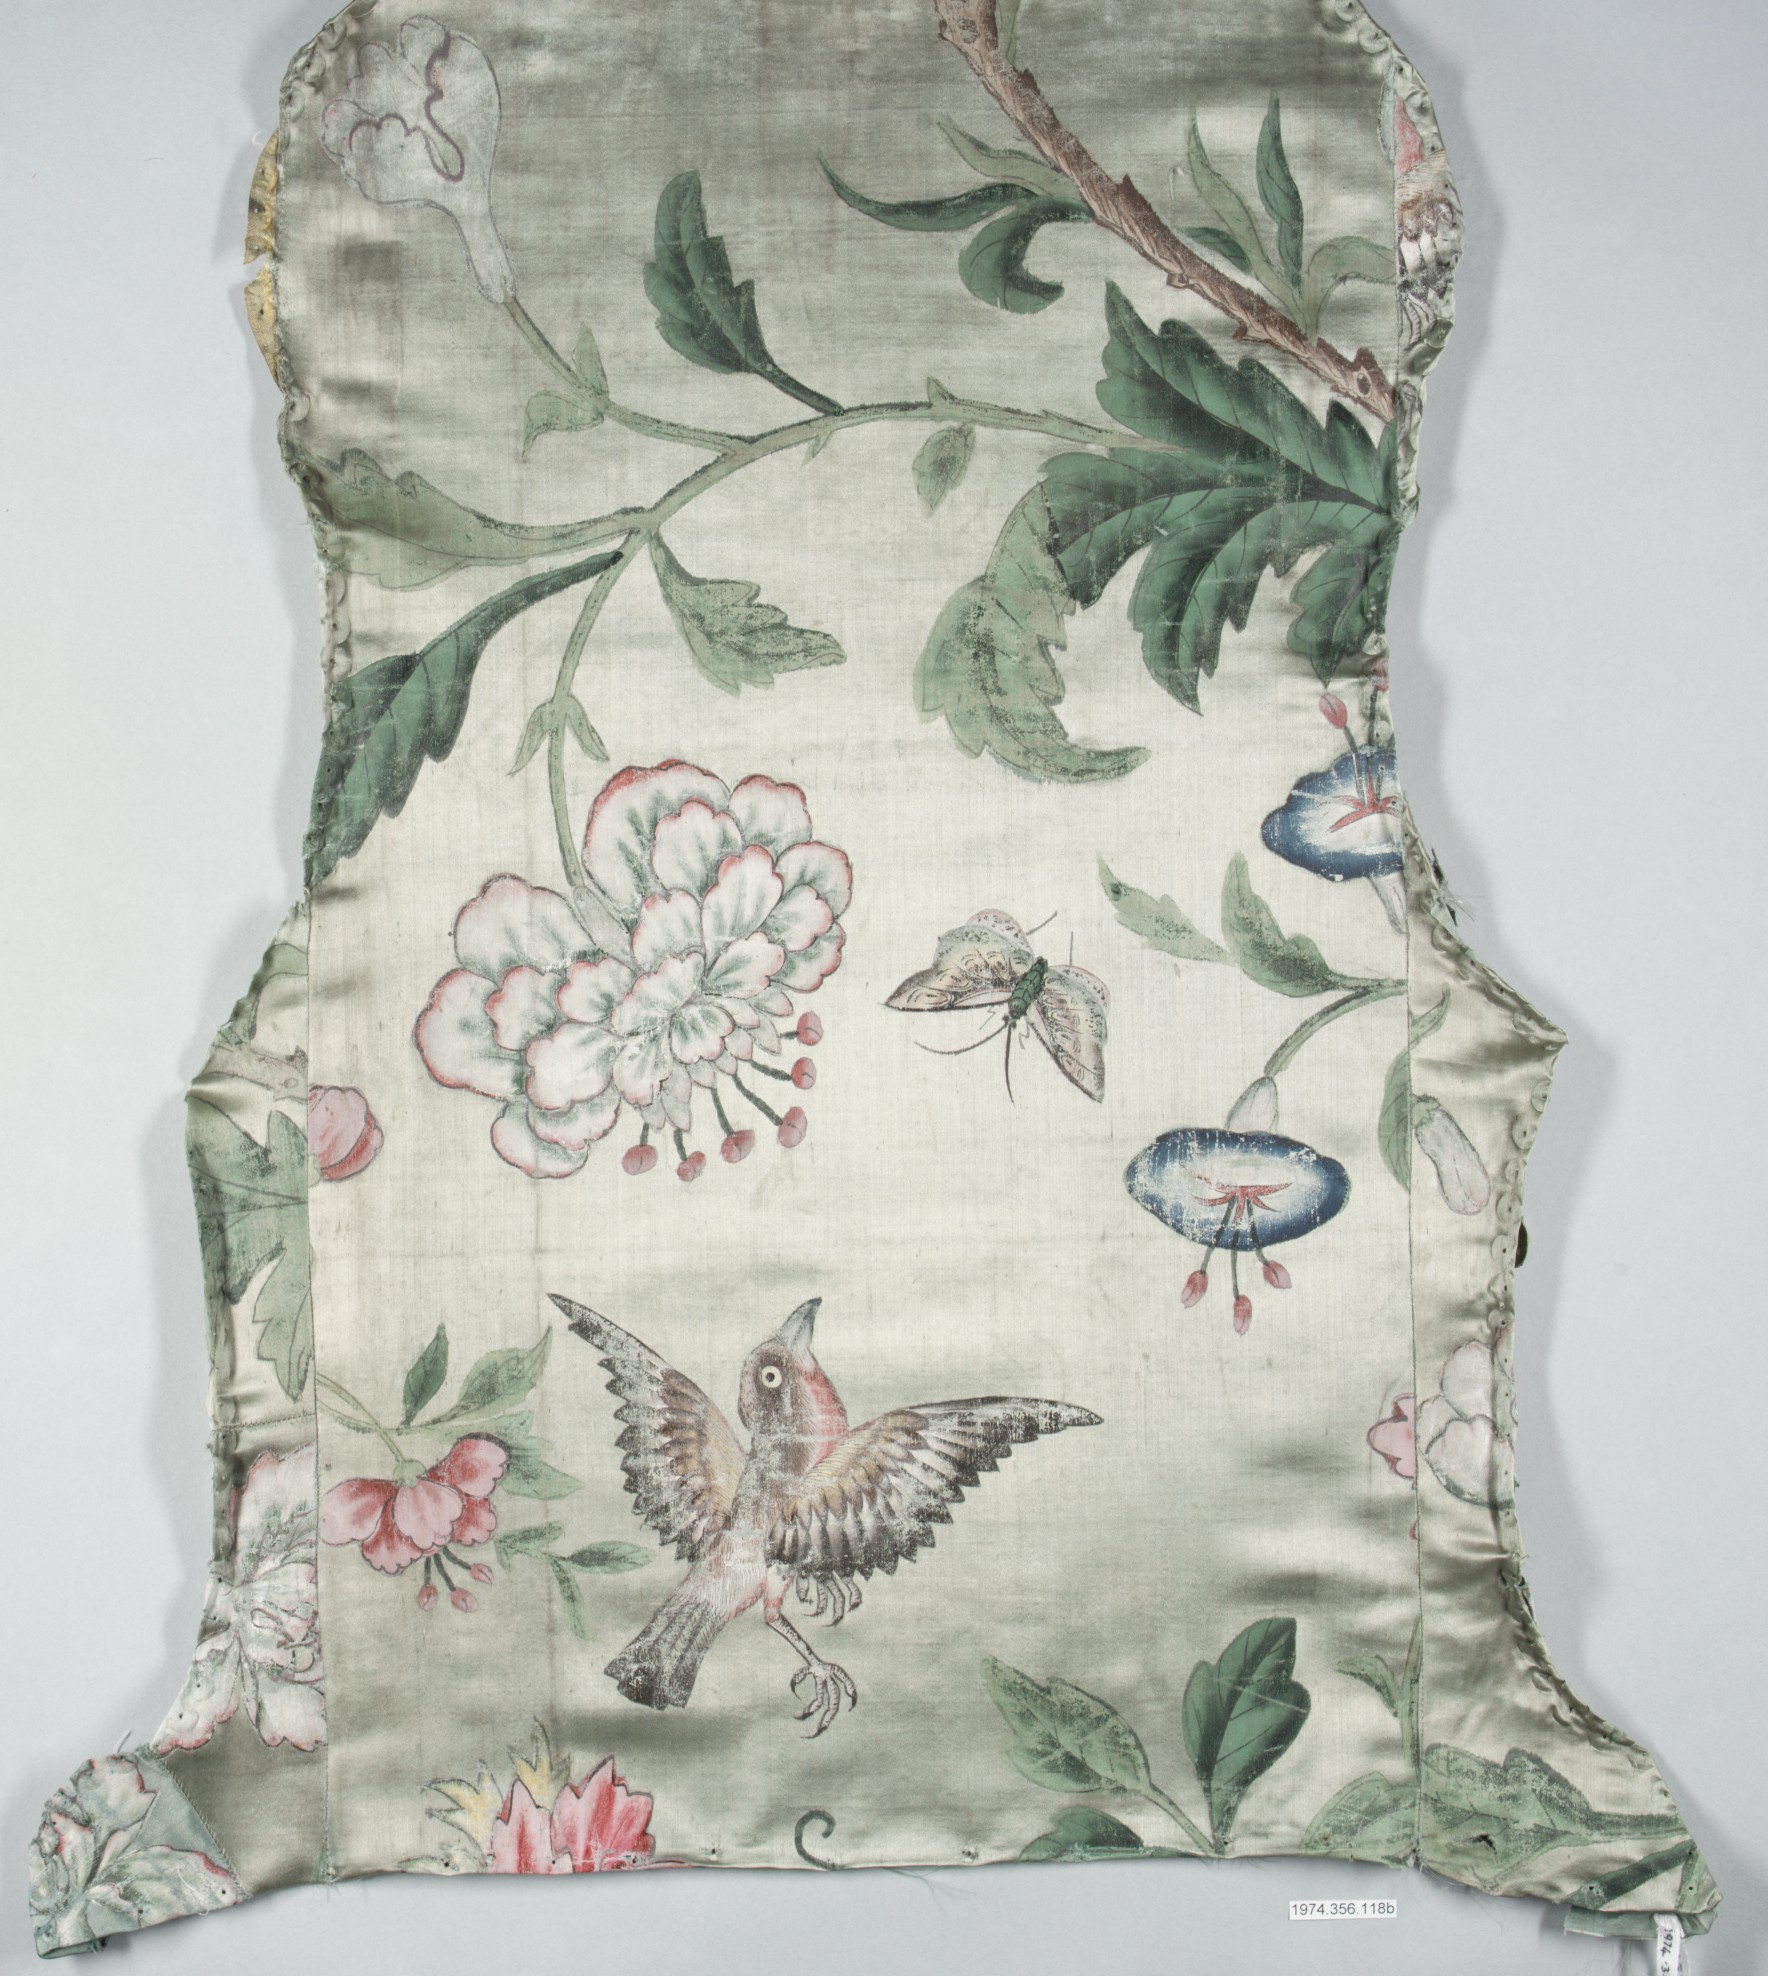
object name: upholstery panel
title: Upholstery panels for an armchair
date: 1763-1764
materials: silk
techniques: painting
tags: birds,butterflies,flowers